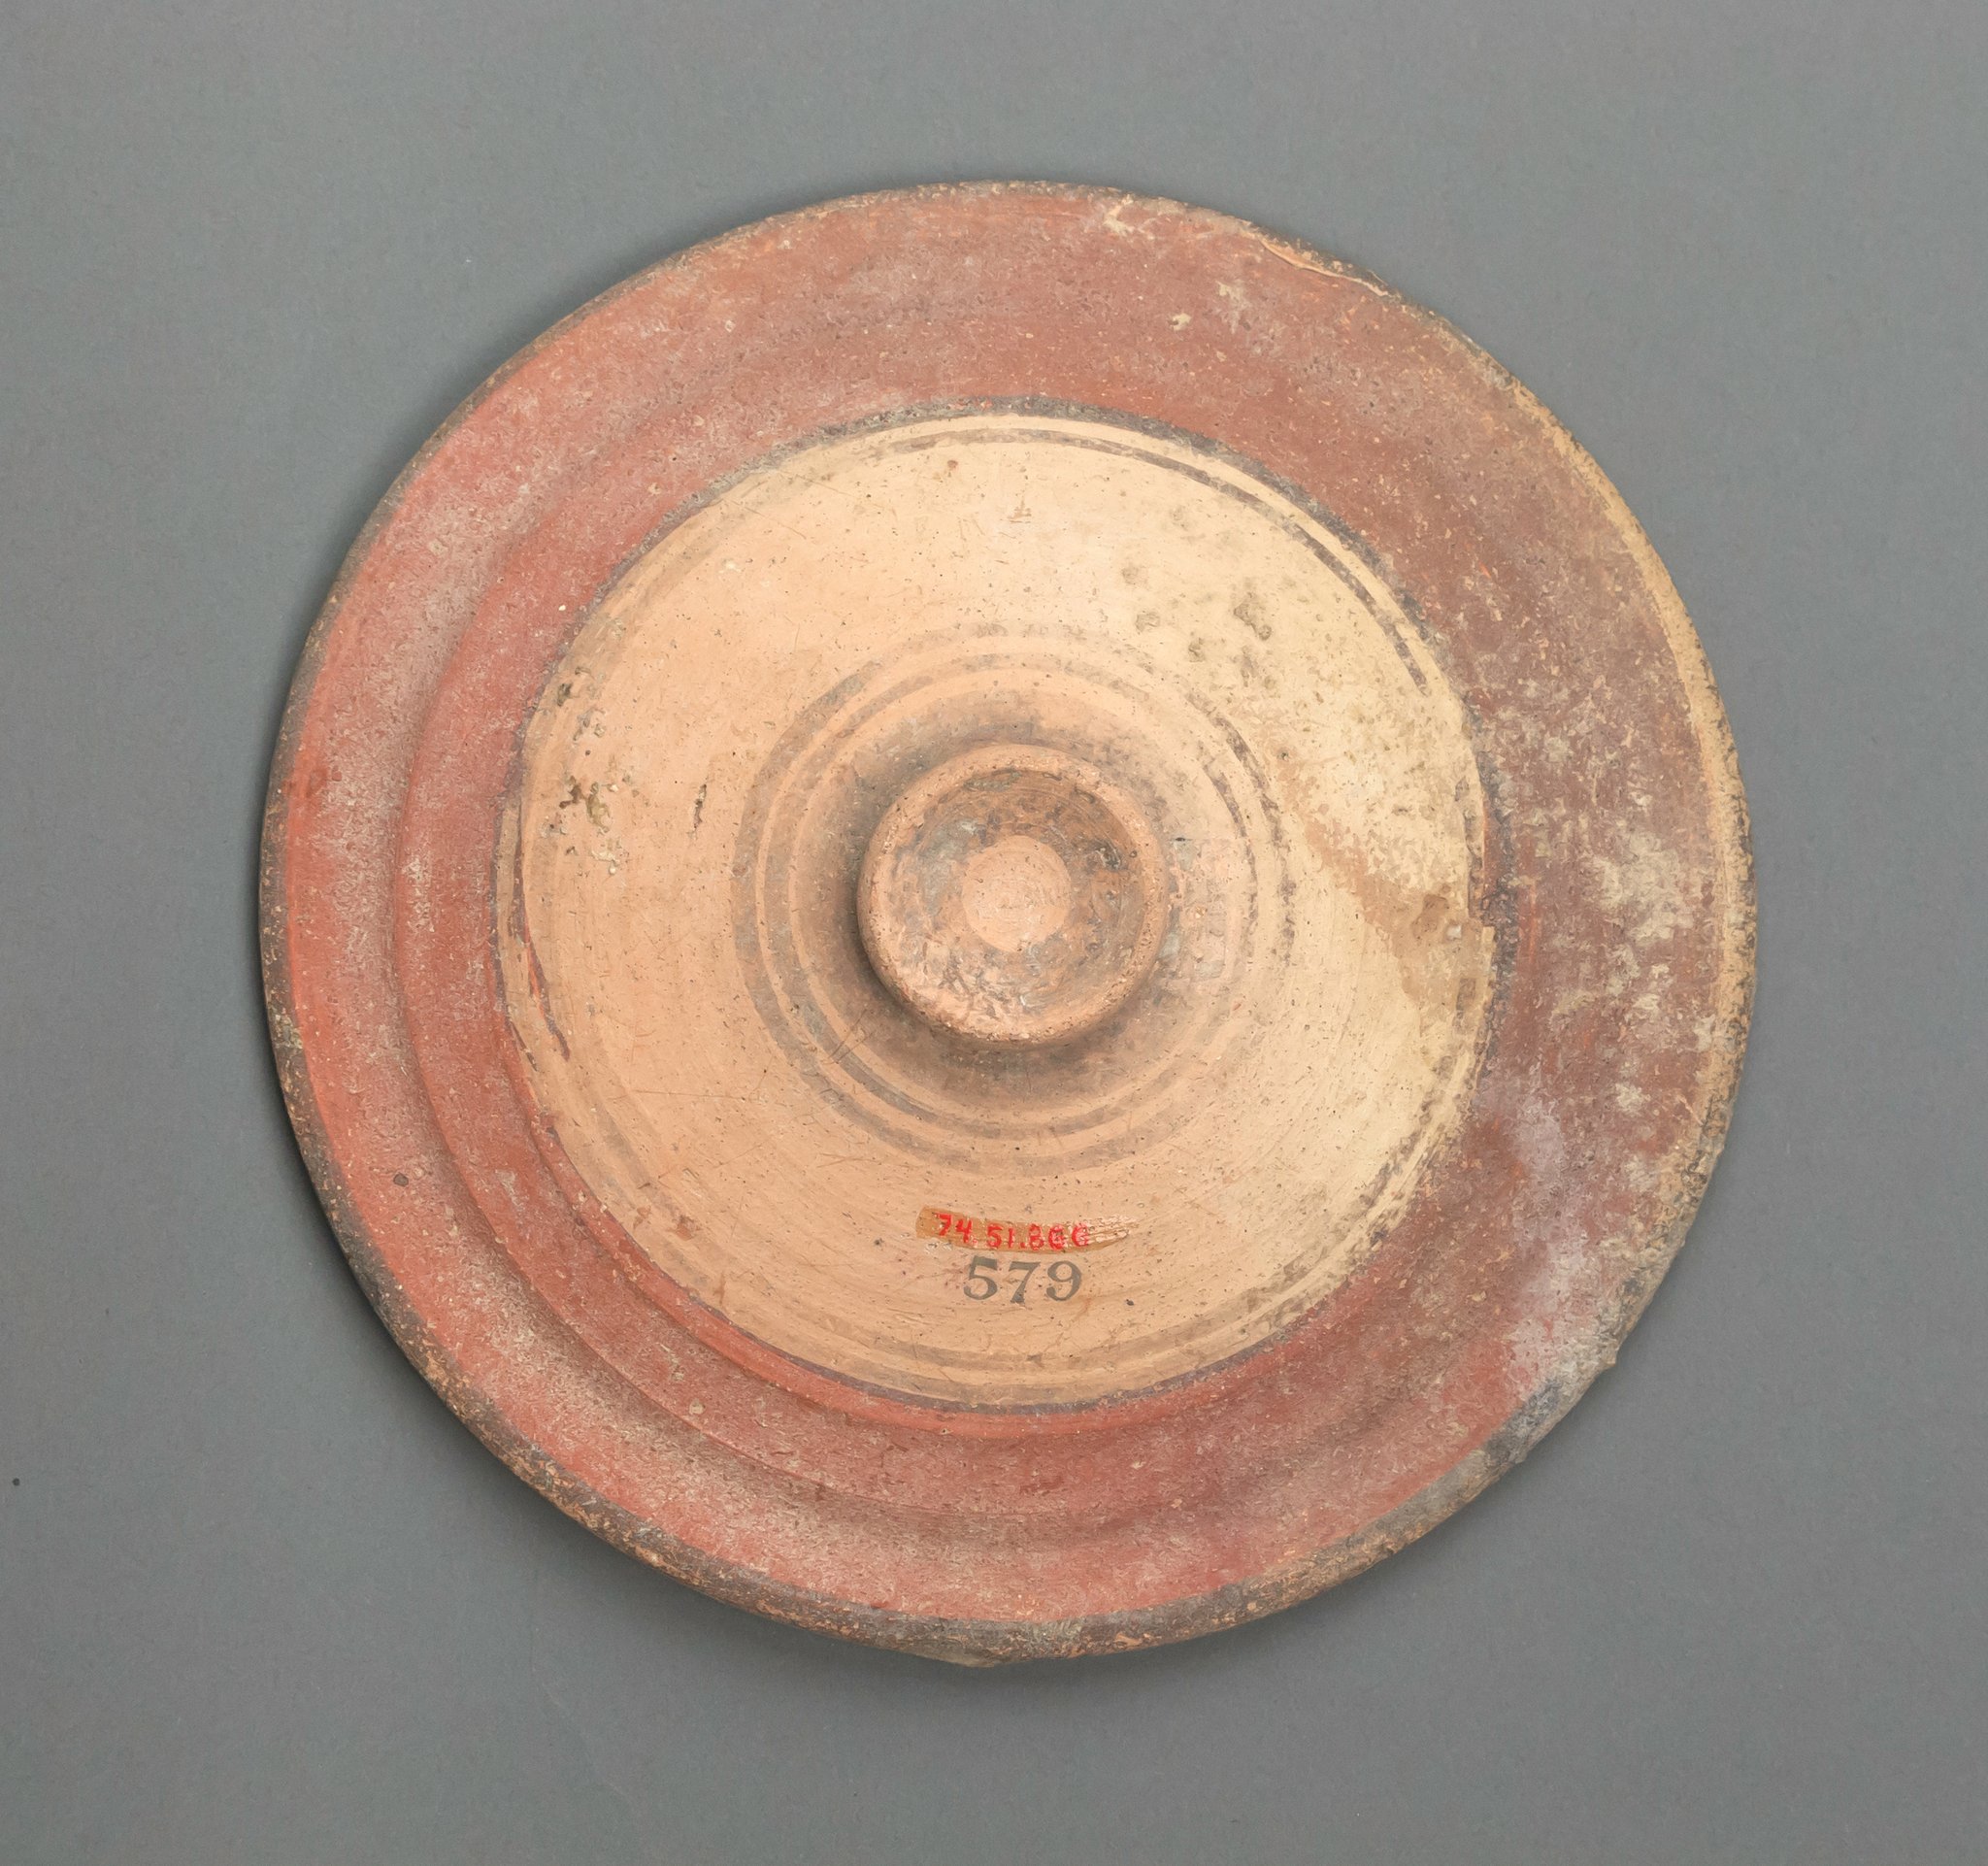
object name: bowl with lid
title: Lid of a bowl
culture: cypriot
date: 600-480 BCE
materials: terracotta